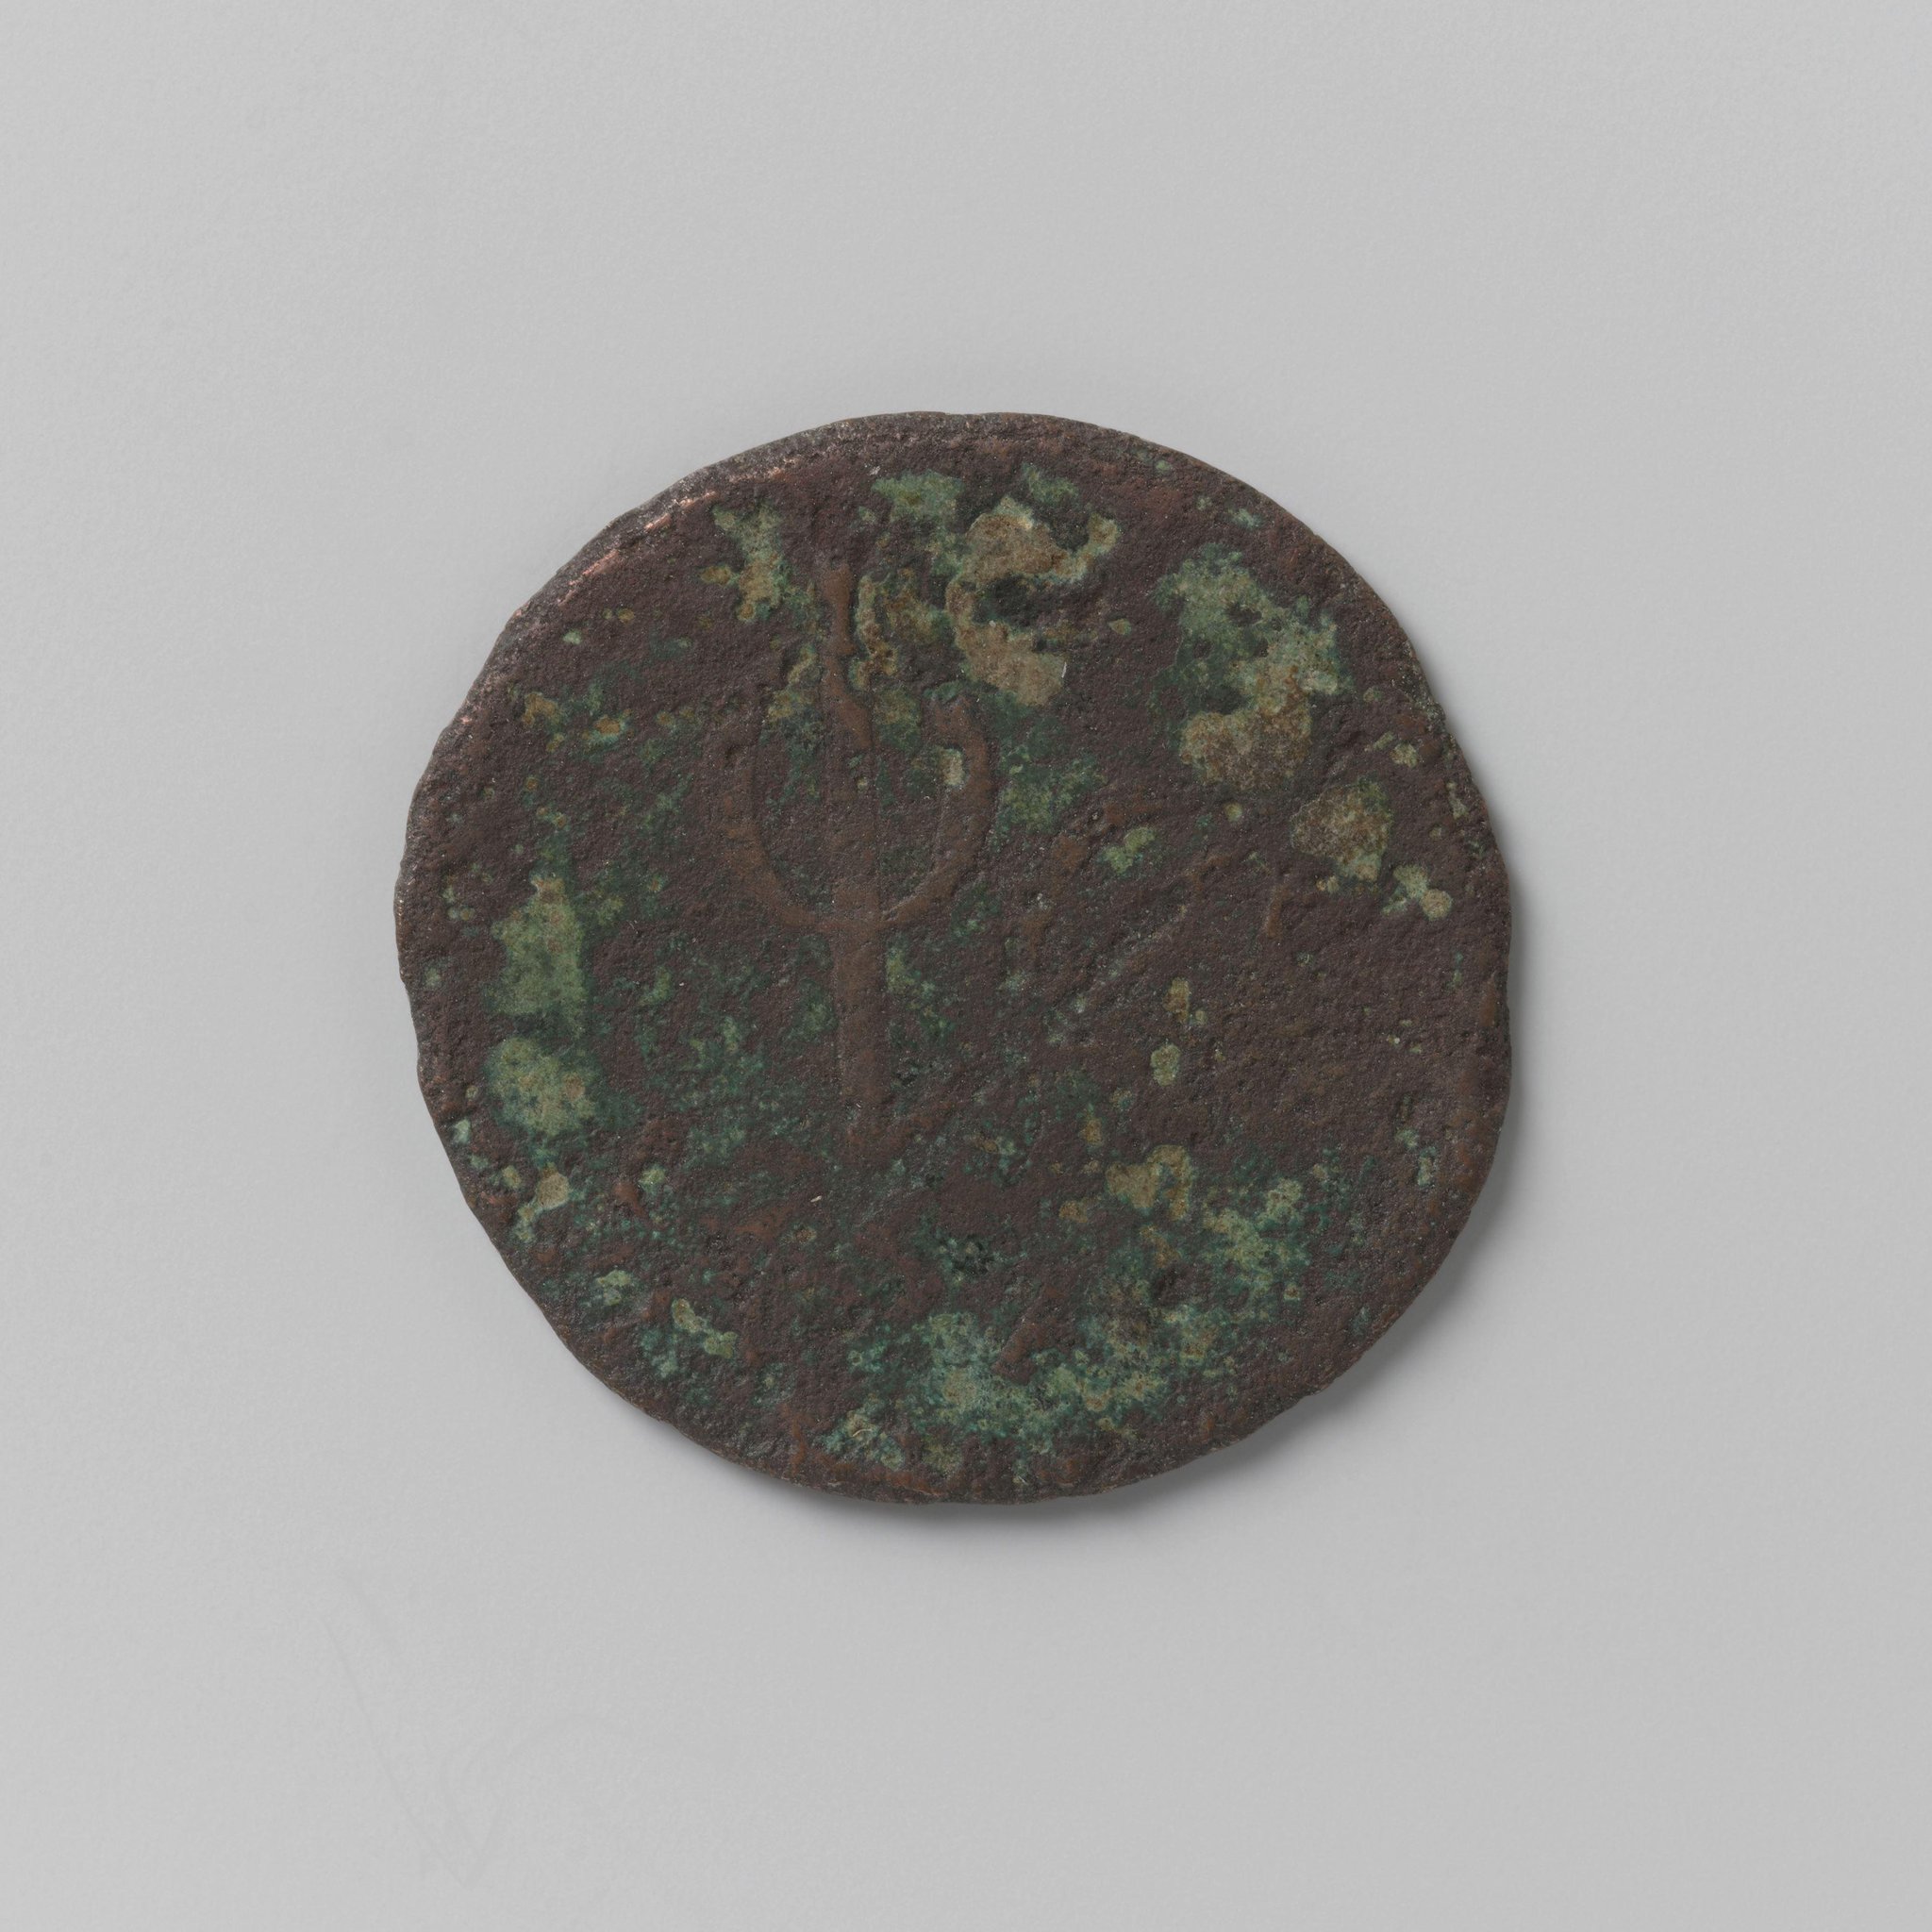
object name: coin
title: ½ duit van de VOC uit de stad Utrecht,1752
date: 1752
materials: copper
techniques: striking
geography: utrecht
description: Koperen munt. Voorzijde: gekroond ingebogen wapenschild van de stad Utrecht. Keerzijde: monogram van de VOC, waarboven muntteken en waaronder jaartal. Gladde rand.